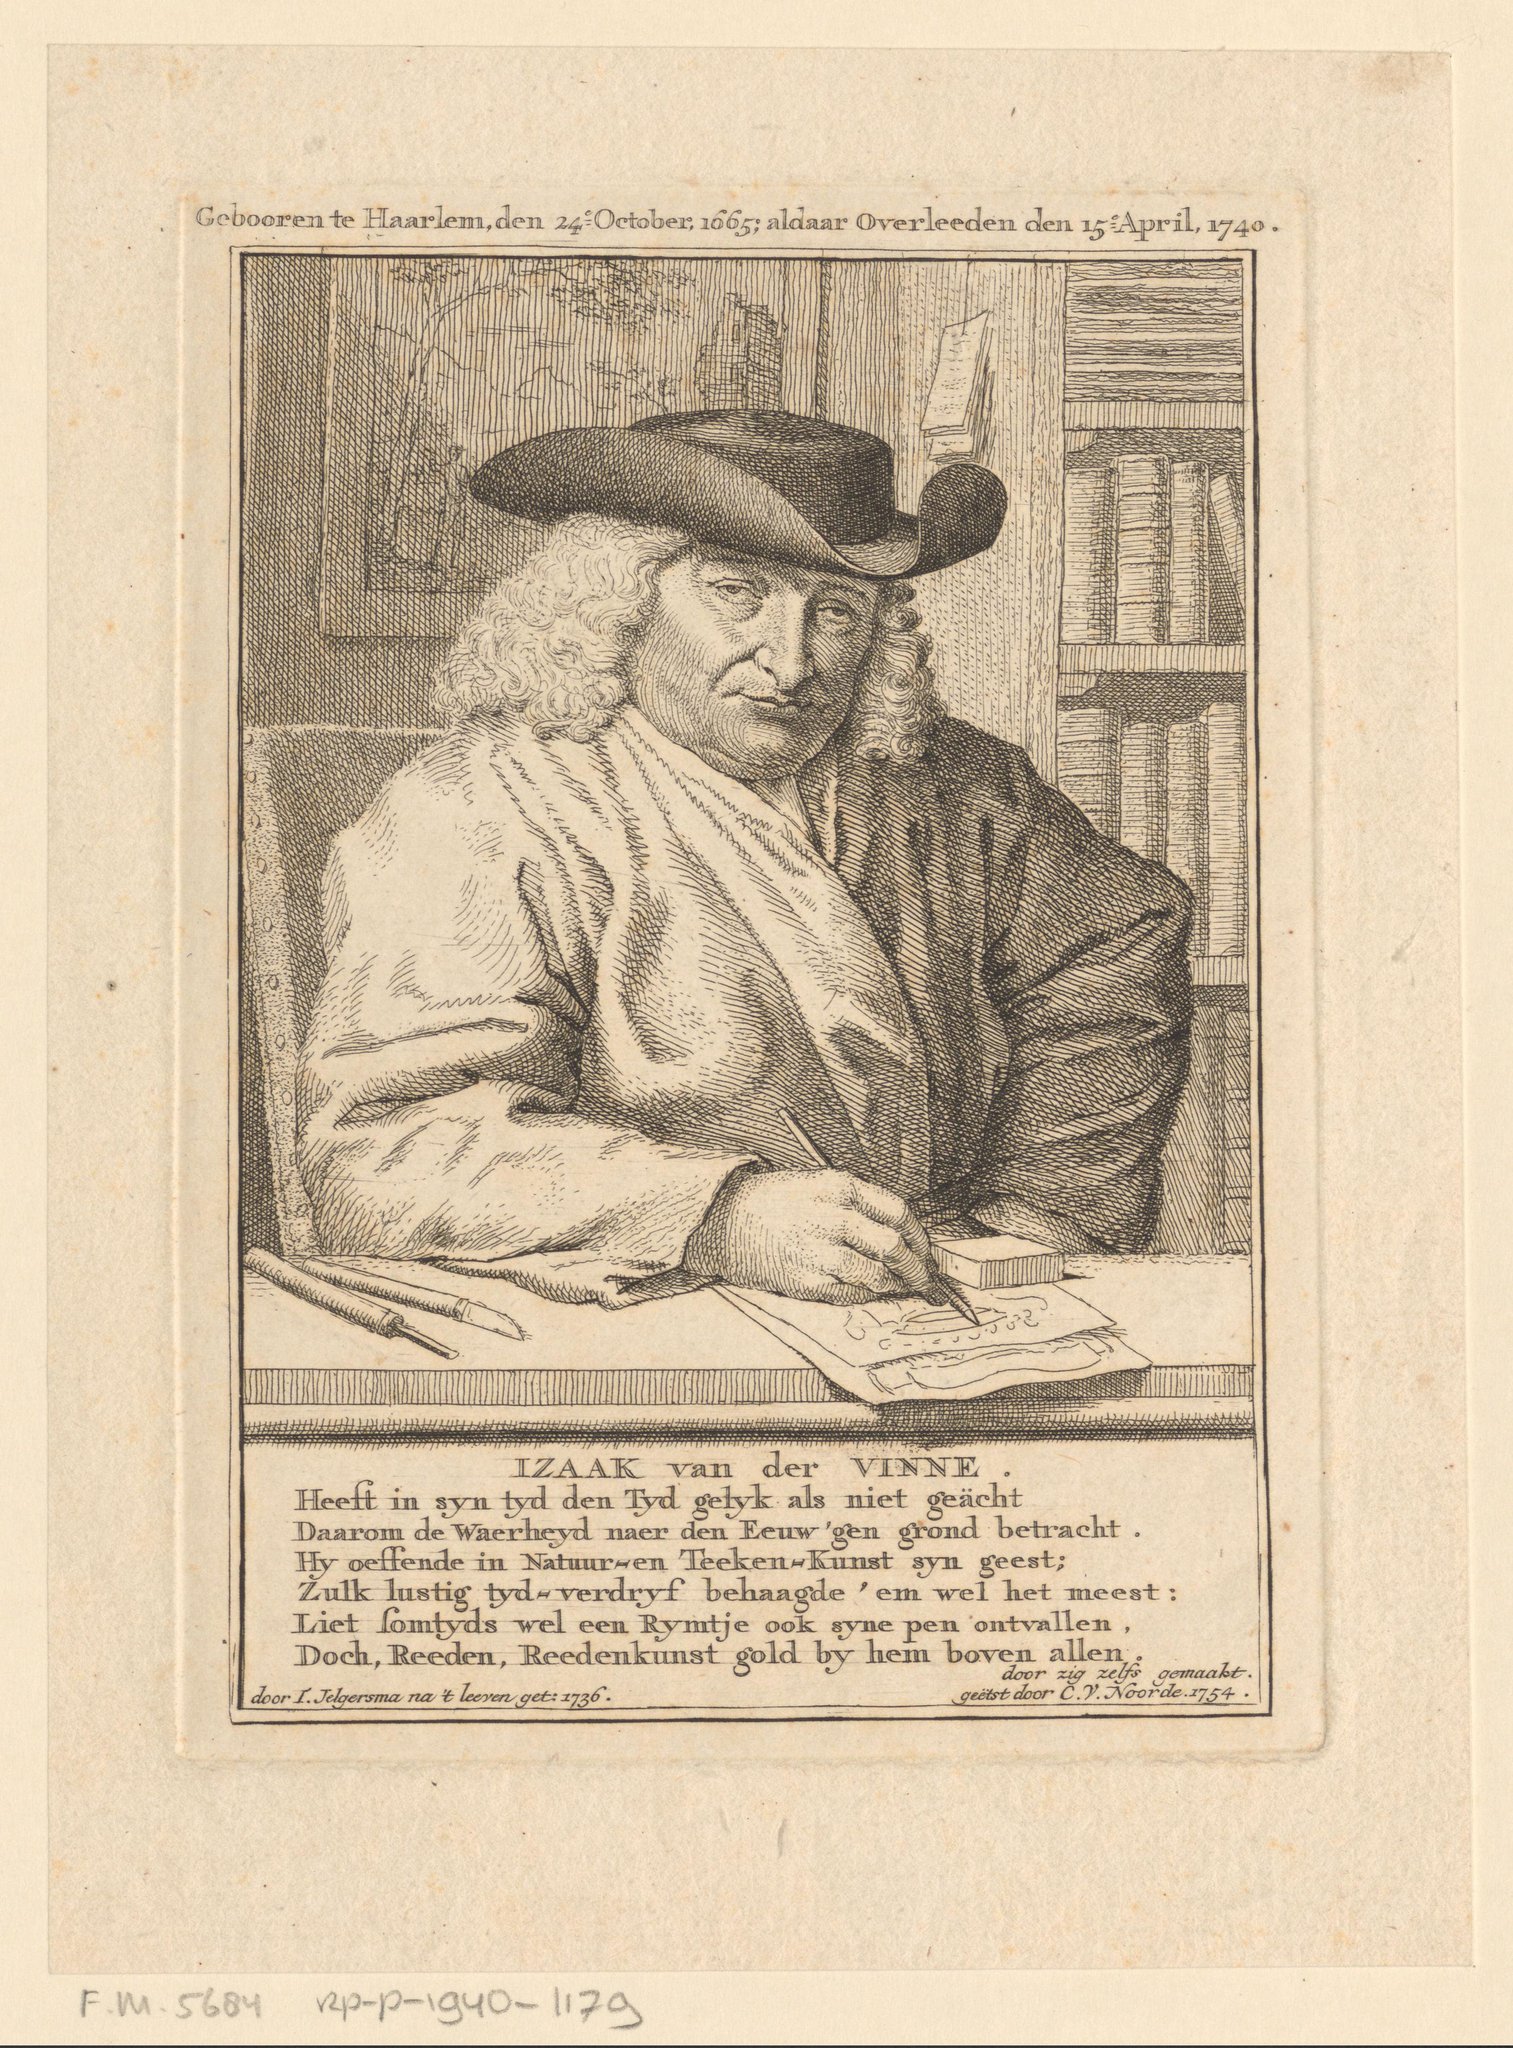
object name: print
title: Portret van Isaac Vincentsz. van der Vinne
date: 1754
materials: paper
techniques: etching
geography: haarlem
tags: haarlem, print maker, draughtsman, isaac vincentsz. van der vinne, historical persons, tools, implements of painter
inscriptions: collector's mark: Lugt 2760, collector's mark: Lugt 2228